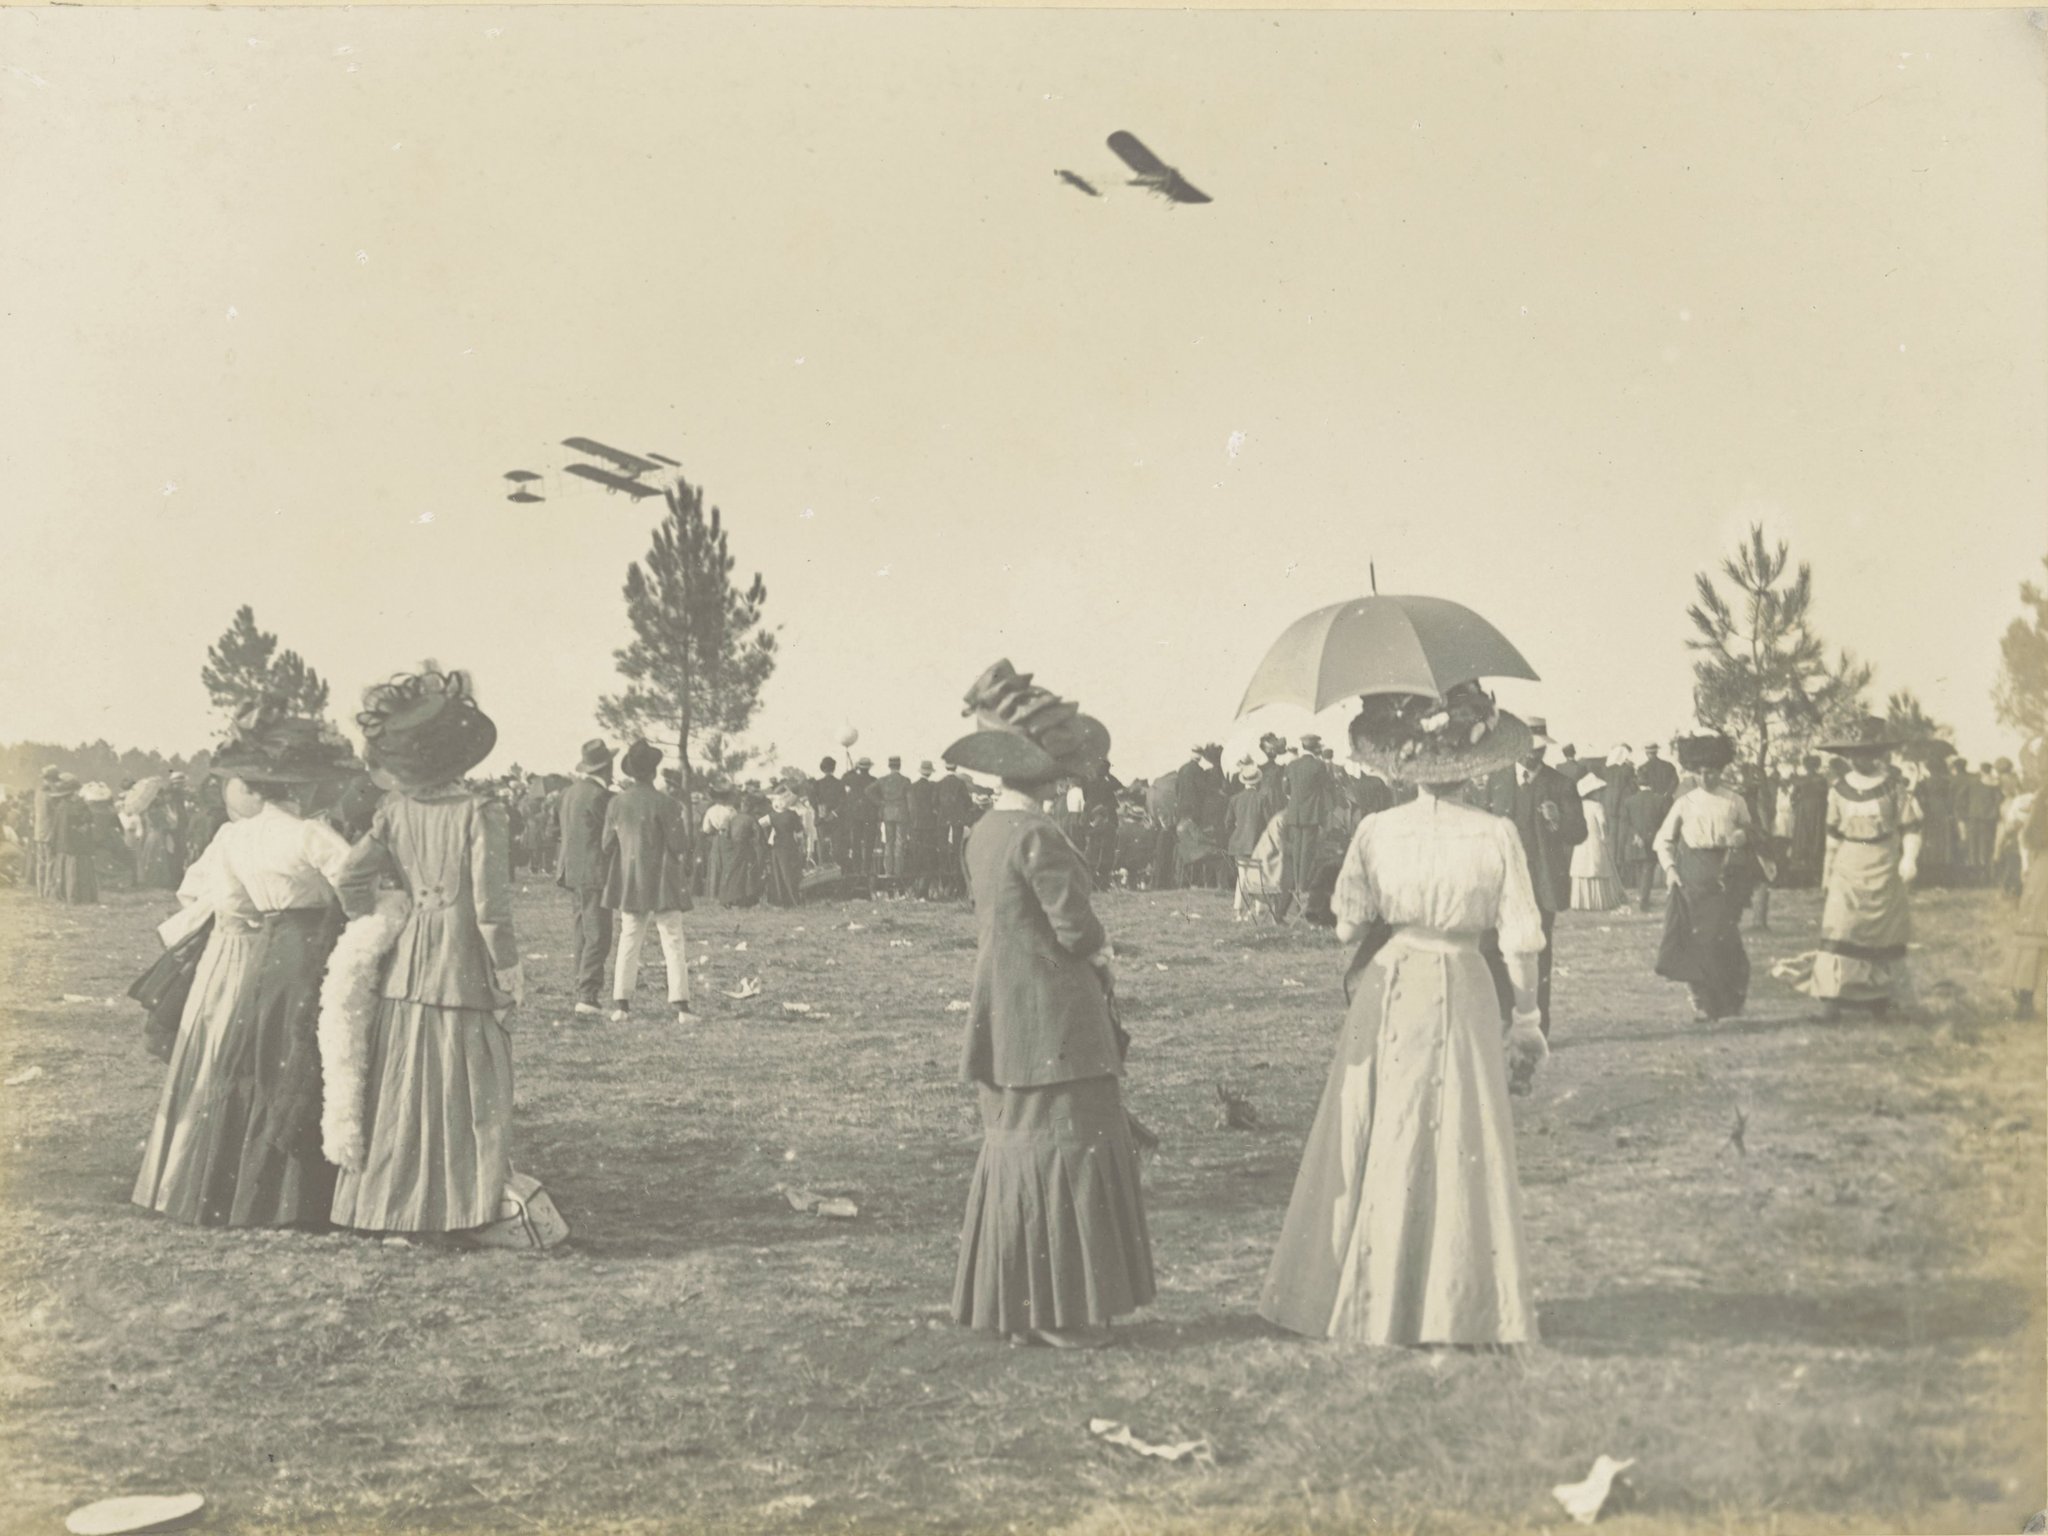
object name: photograph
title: Publiek dat kijkt naar een aantal vliegtuigen, Frankrijk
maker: Anonymous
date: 1910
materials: paper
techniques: gelatin silver print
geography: france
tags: aircraft, aeroplane, france